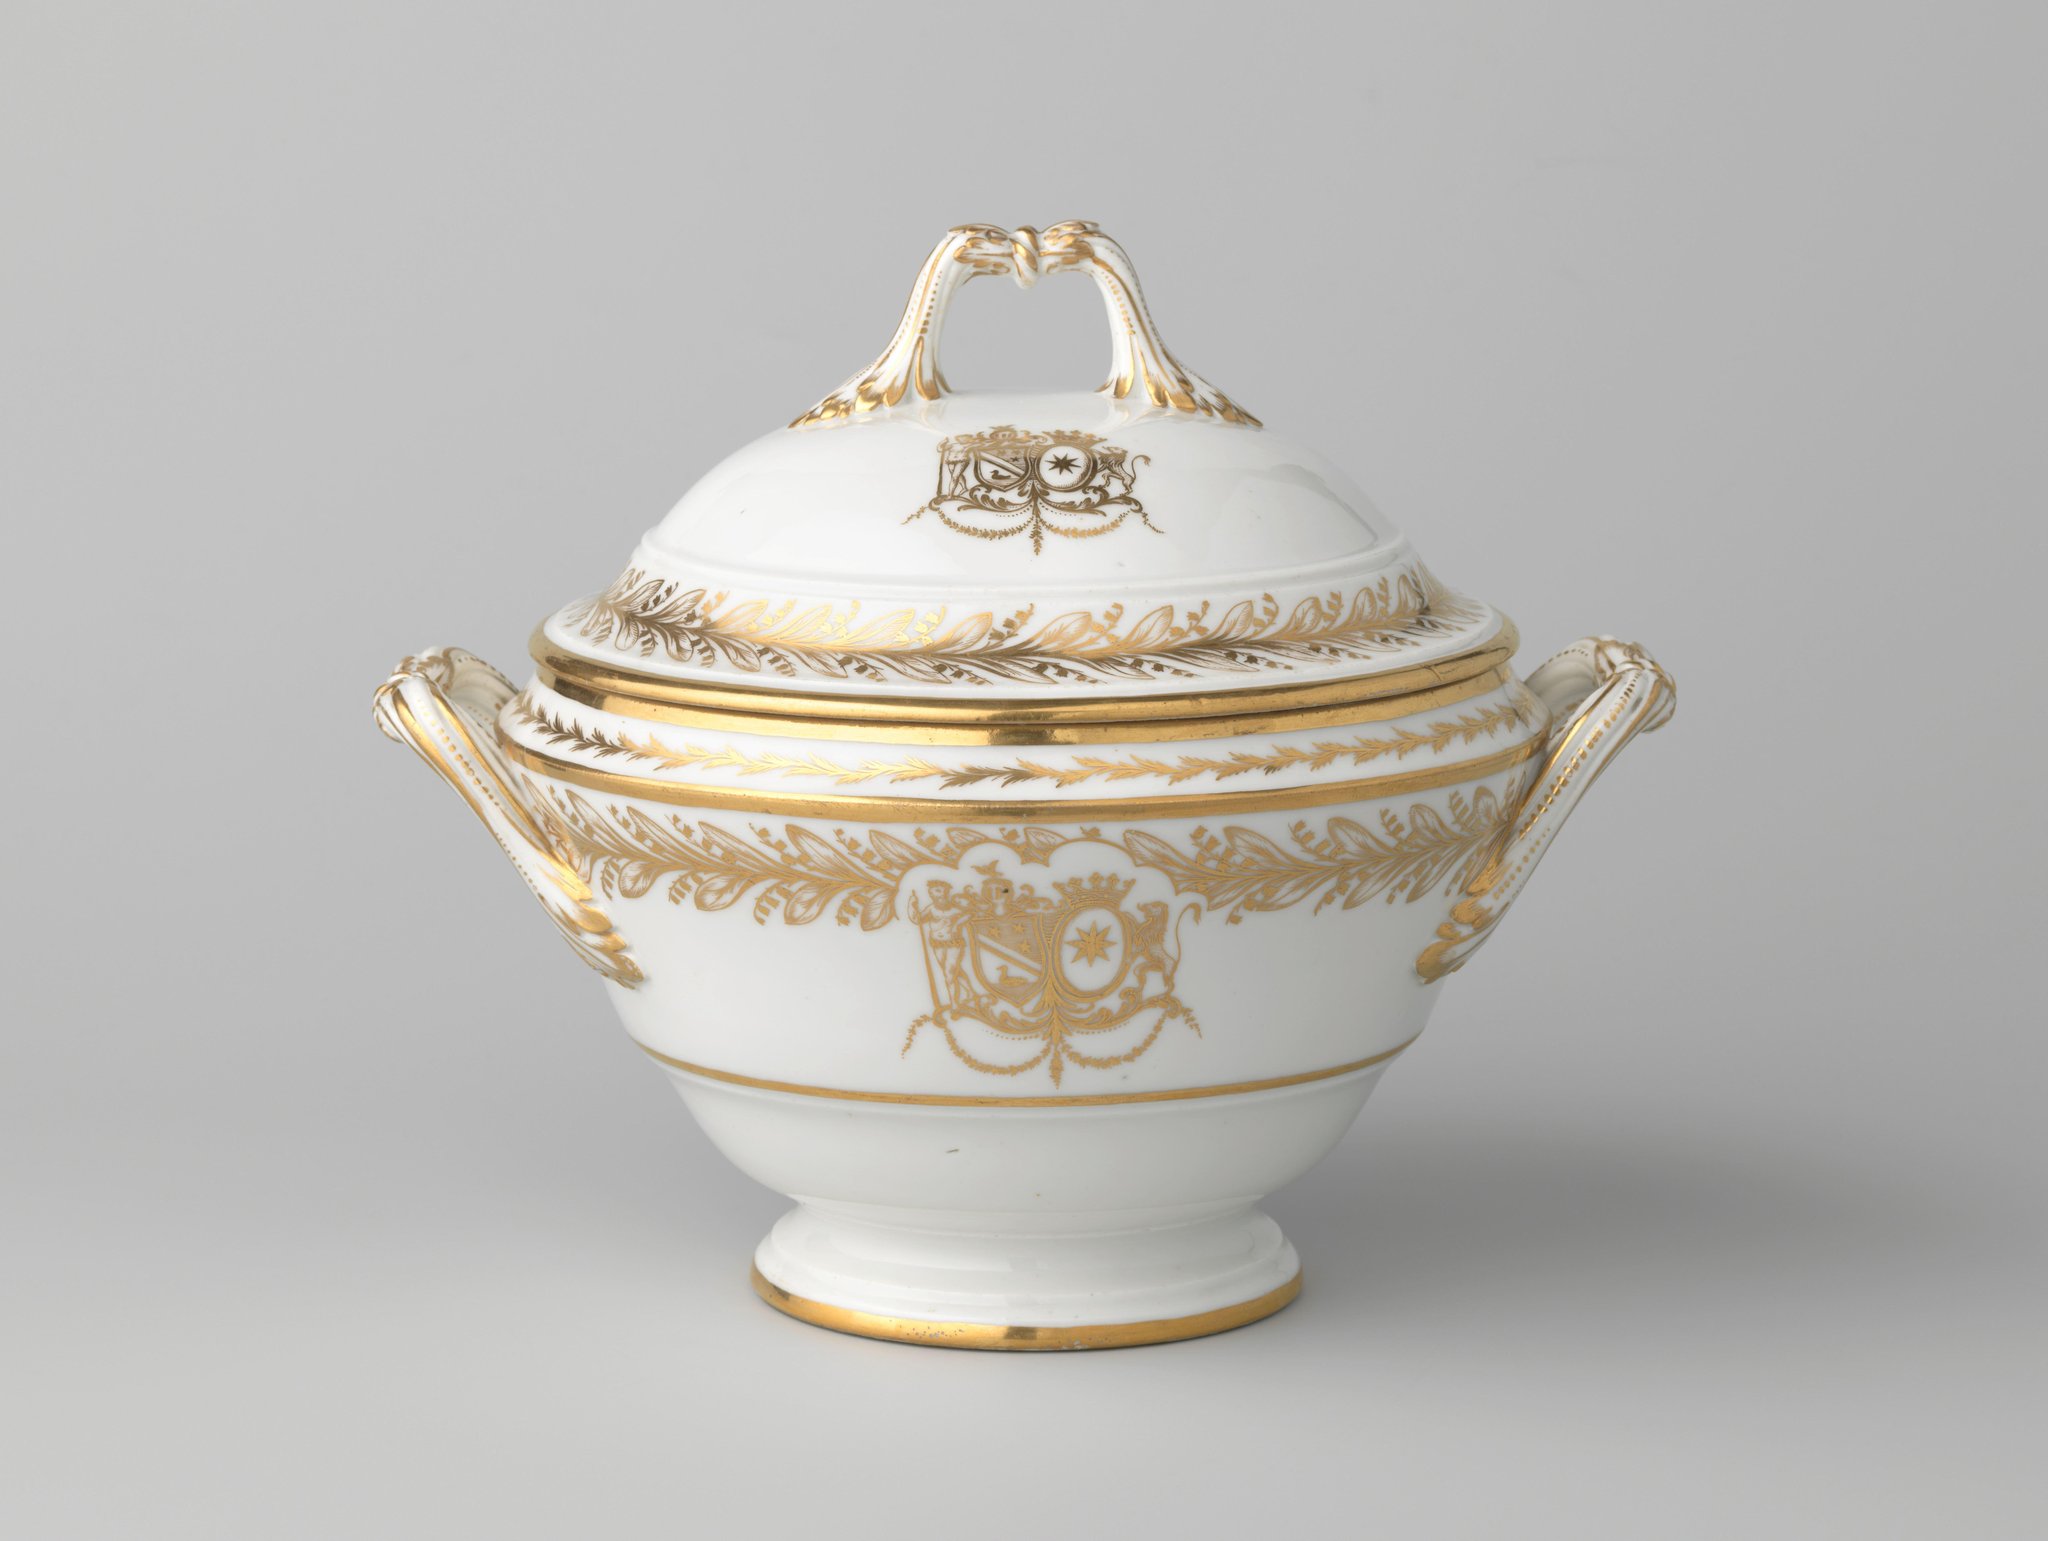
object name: service set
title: Cover of a tureen with the coat of arms of Hendrik Peter Godfried Quack and Isabella Gertraud von Carnap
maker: Anonymous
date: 1790-1800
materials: glaze, gold, paint, porcelain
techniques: firing, forming, gilding, turning, vitrification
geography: paris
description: Deksel van een terrine van porselein met een opstaand handvat, beschilderd op het glazuur met goud. Versierd met het alliantiewapen van Hendrik Peter Godfried Quack en Isabella Gertraud von Carnap en een bloemrank. Gouden band op de rand. Het handvat is in de vorm van twee bladranken.